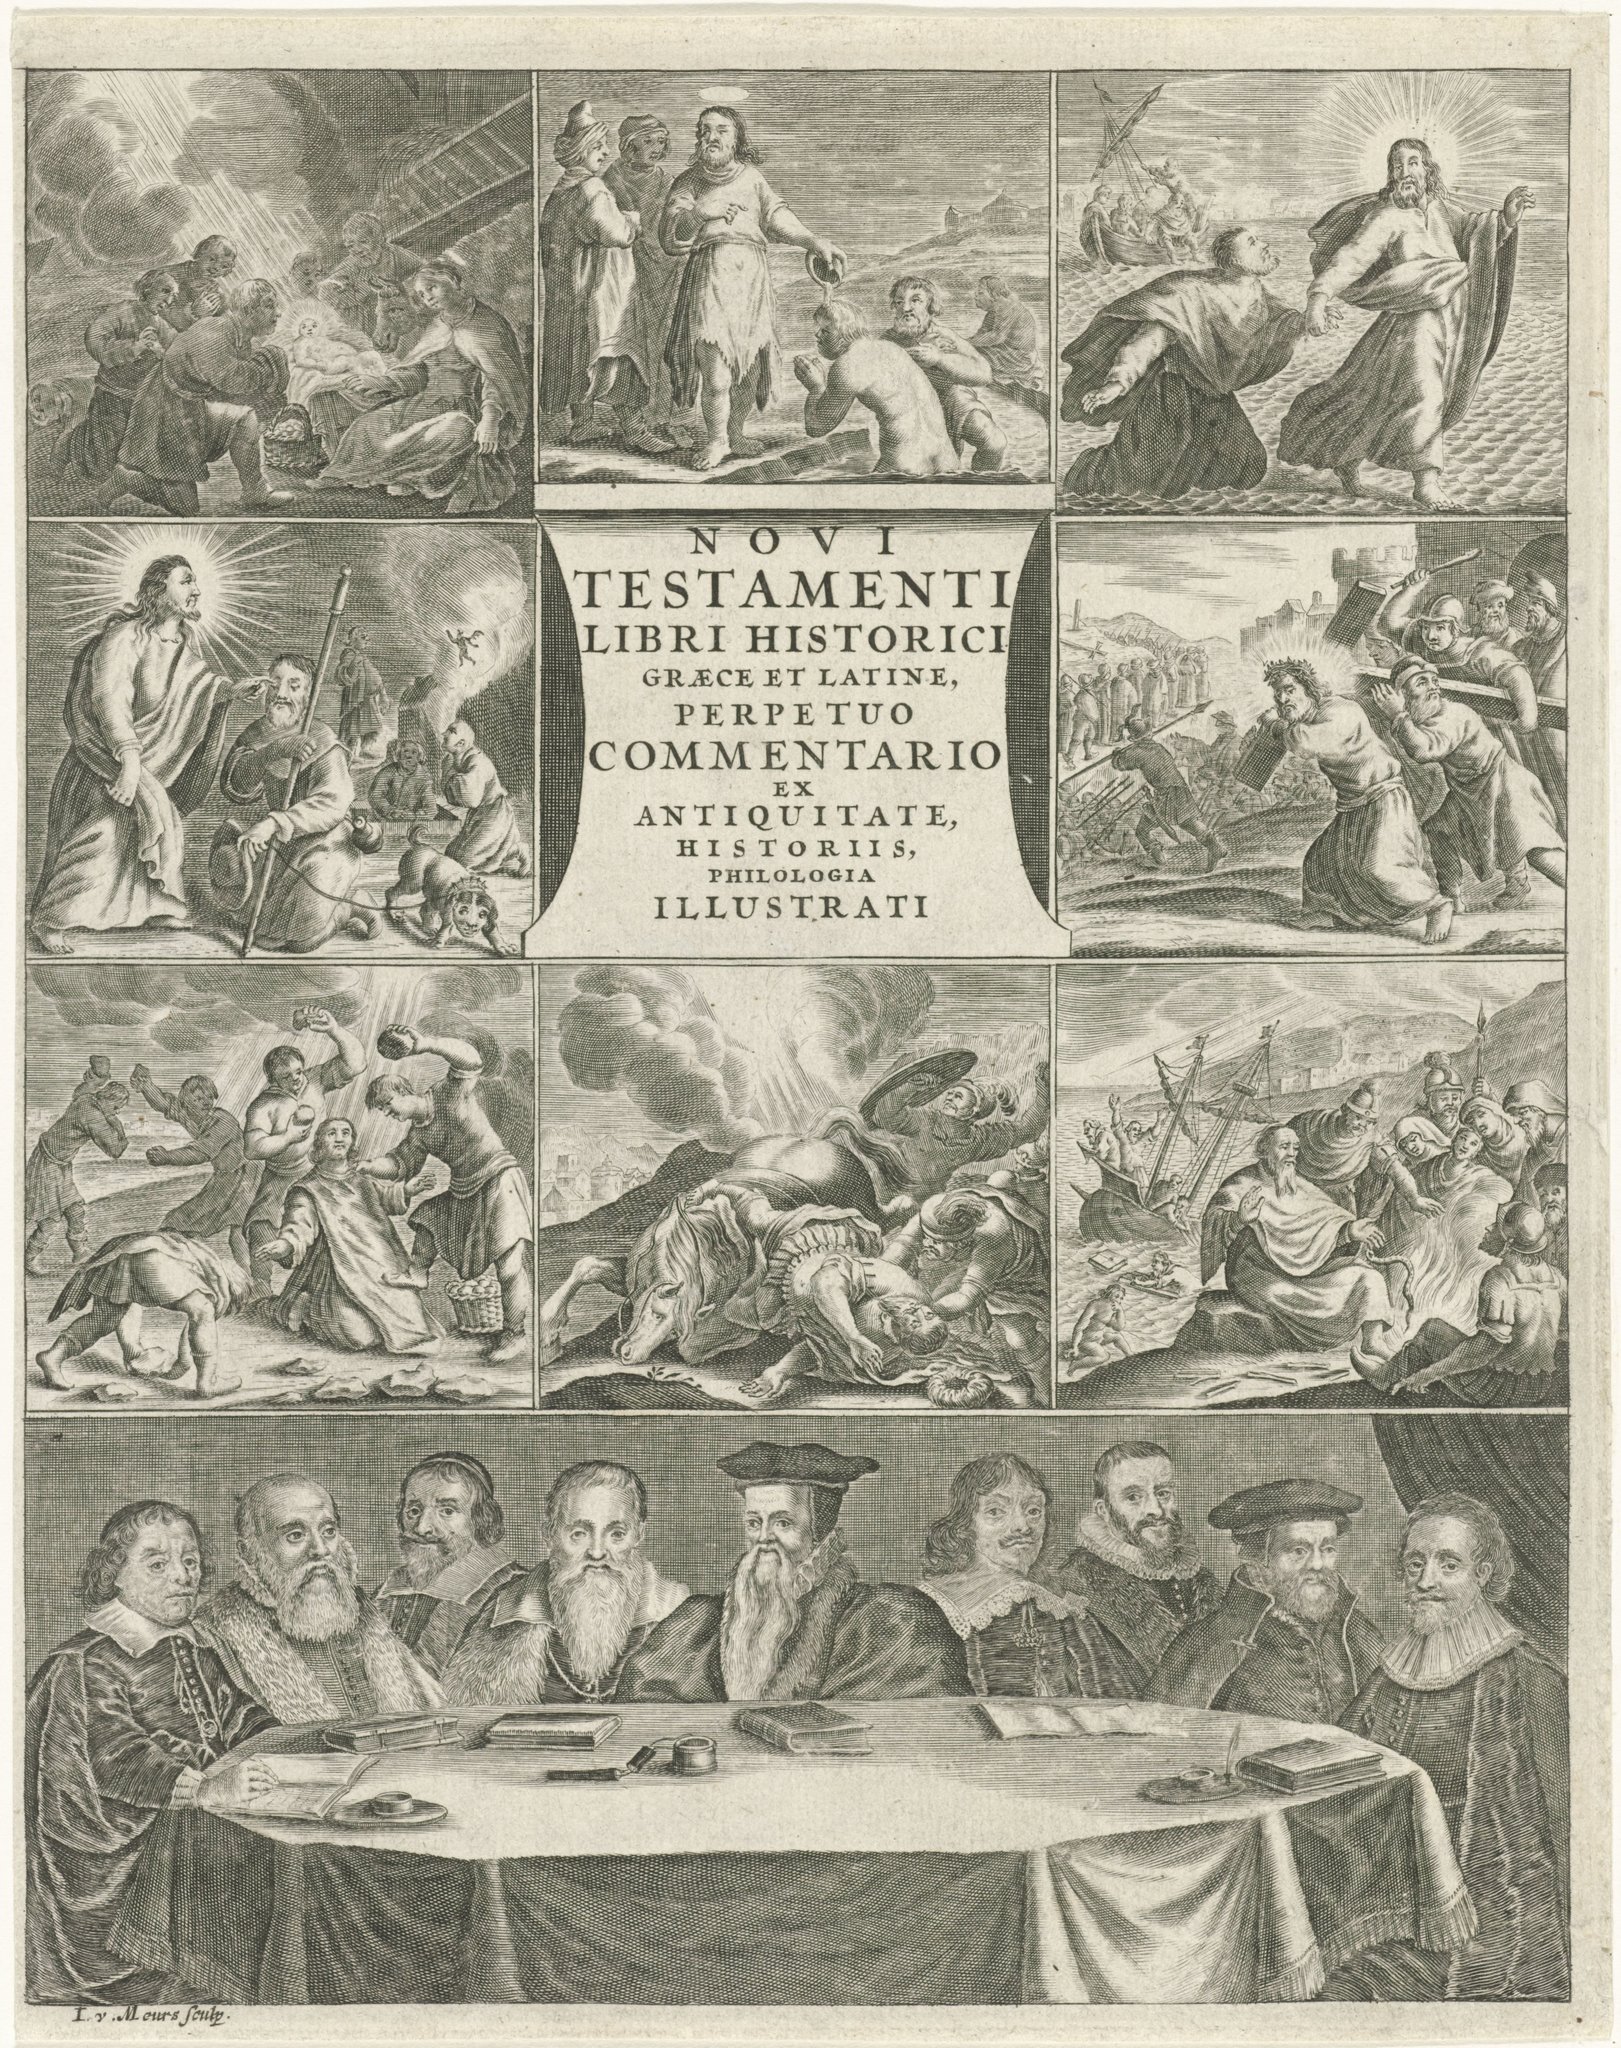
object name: titelblad, titelpagina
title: Voorstellingen uit het Nieuwe Testament en negen geleerden rond een tafel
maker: jacob van meurs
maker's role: draughtsman, print maker, publisher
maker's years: 1619-1680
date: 1653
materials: paper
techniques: engraving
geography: amsterdam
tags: delft, hugo de groot, claudius salmasius, theodorus beza, bruges, amberg, ghent, leiden, daniël heinsius, john the baptist baptizing, adoration of the christ-child by the shepherds; mary and joseph present, on the way to damascus christ appears to saul, who falls from his horse and is blinded by the light, the stoning of stephen; the witnesses lay down their clothes at saul's feet, christ healing blind people, christ saves peter from drowning, carrying of the cross: christ bearing the cross, alone or with the help of others (e.g. simon the cyrenian), after the shipwreck paul and his men are kindly received by the inhabitants of malta, who make fire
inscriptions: collector's mark: Lugt 2760, collector's mark: Lugt 2228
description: Acht voorstellingen uit het Nieuwe Testament. Van rechts naar links en van boven naar beneden: de aanbidding door de herders, Johannes de Doper doopt een man, Christus met Petrus aan de hand lopend op het water, genezing van een blinde, de kruisdraging, de steniging van Stefanus, de bekering van Paulus en Paulus op Malta. Midden onder negen geleerden en theologen rond een tafel, onder wie Daniël Heinsius, Josephus Scaliger, Franciscus Gomarus, Frederick Spanheim (I), Theodorus Beza, Clausius Salmasius en Hugo de Groot.